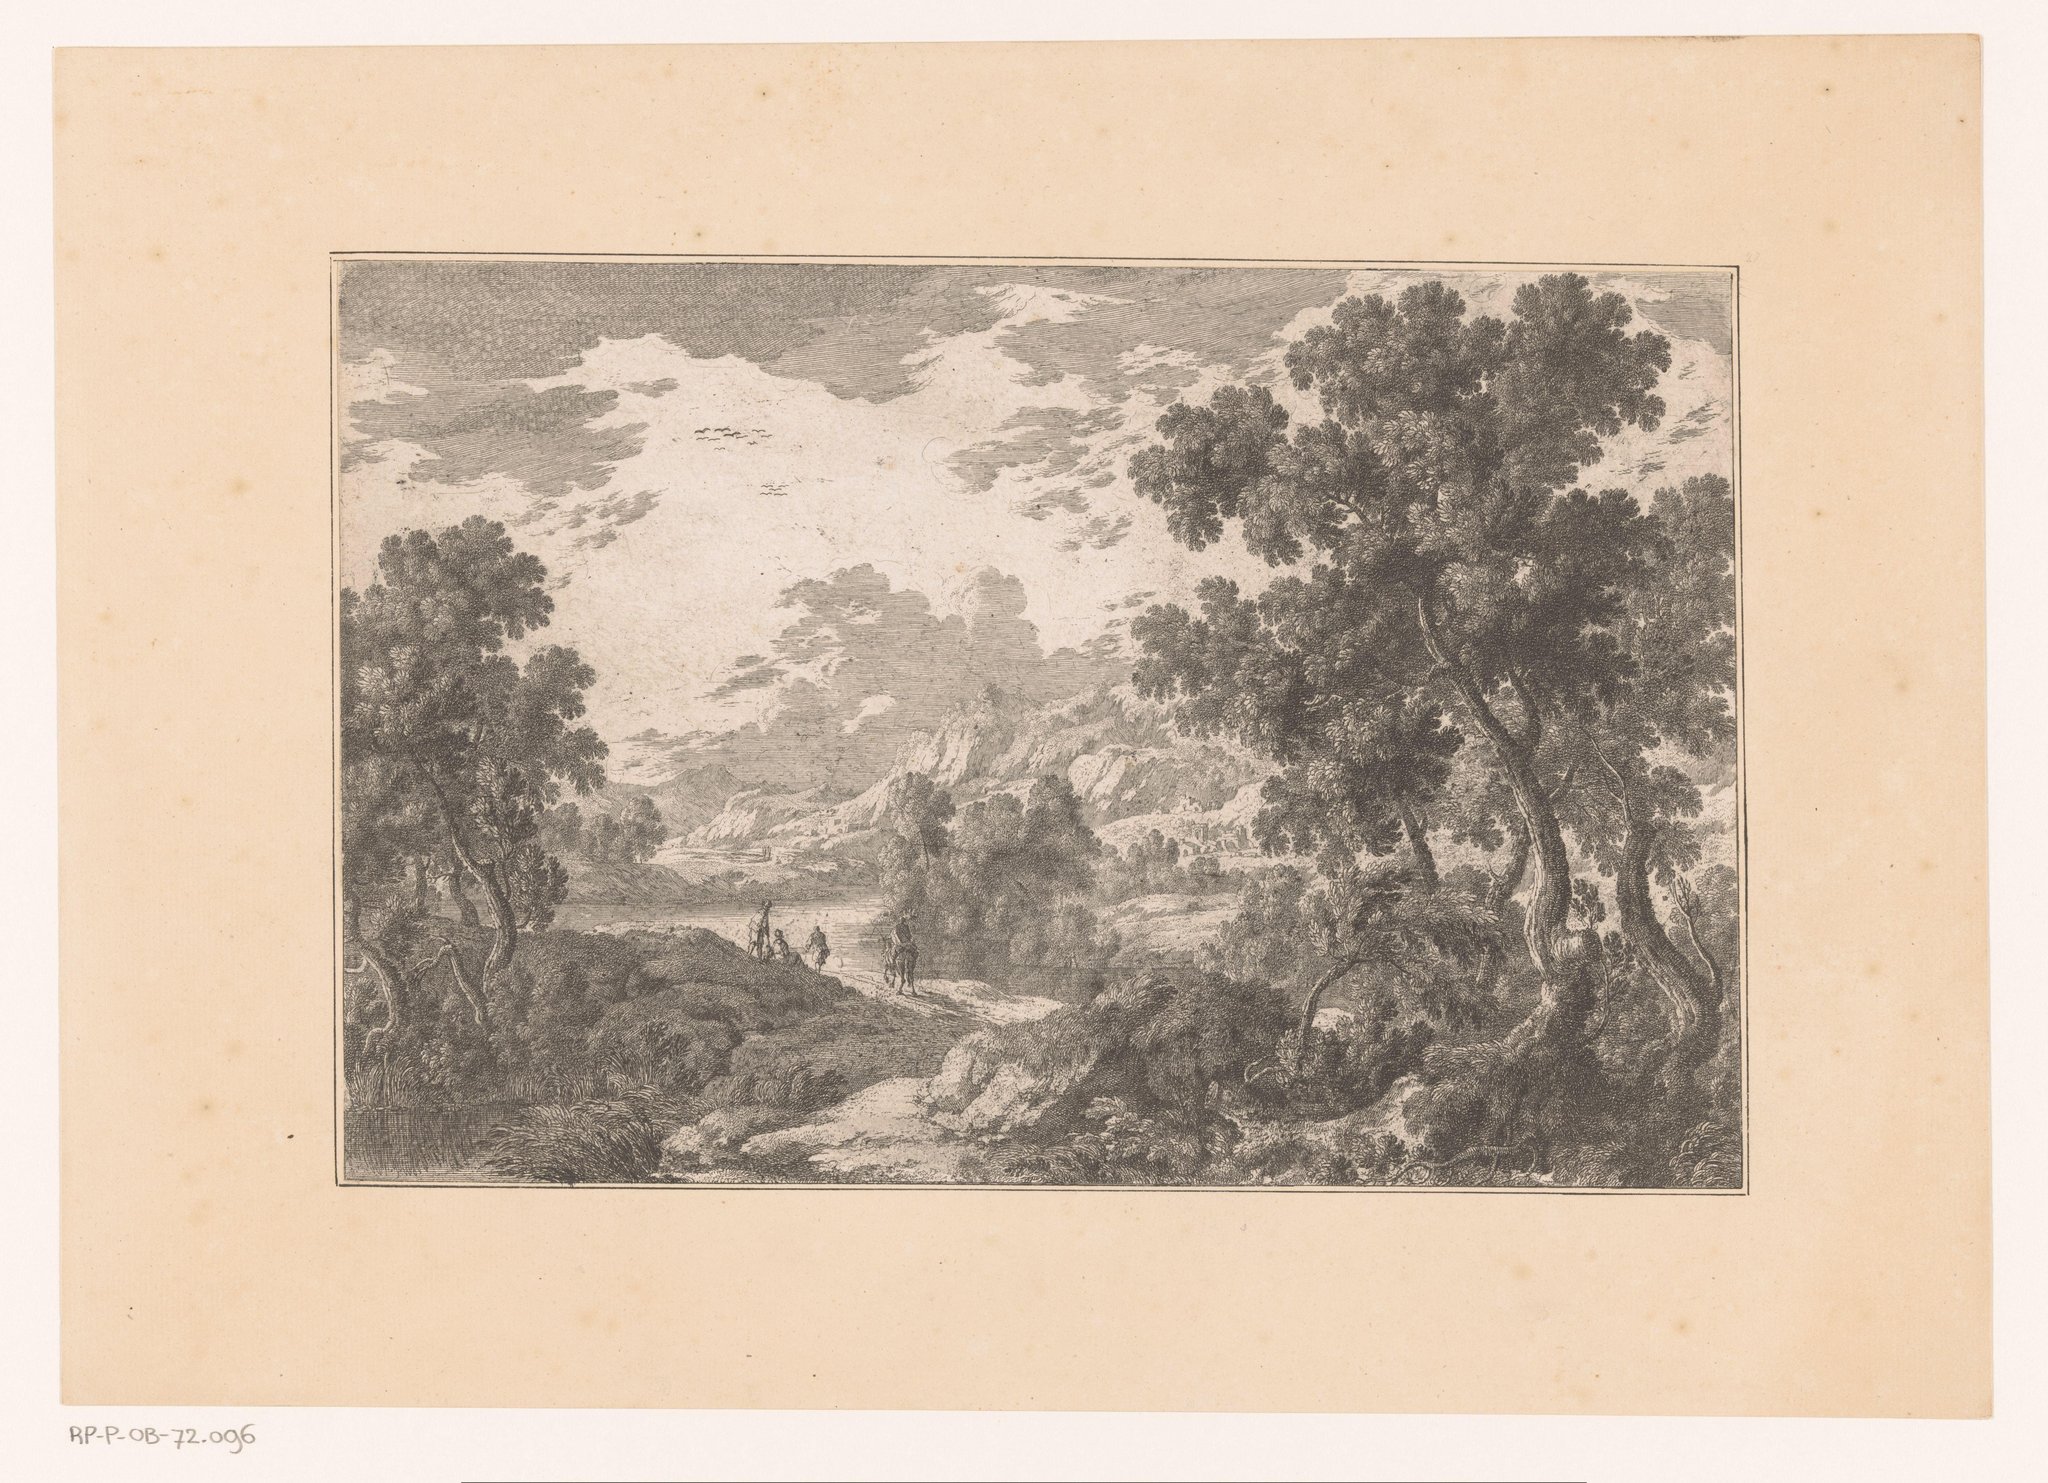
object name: print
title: Rivierlandschap met vier figuren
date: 1673-1695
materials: paper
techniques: engraving, etching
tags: landscapes with waters, waterscapes, seascapes (in the temperate zone)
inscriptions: collector's mark: Lugt 240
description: Prenten met het signatuur 'Perelle' kunnen zowel door vader Gabriel als door zonen Nicolas en Adam gemaakt zijn.